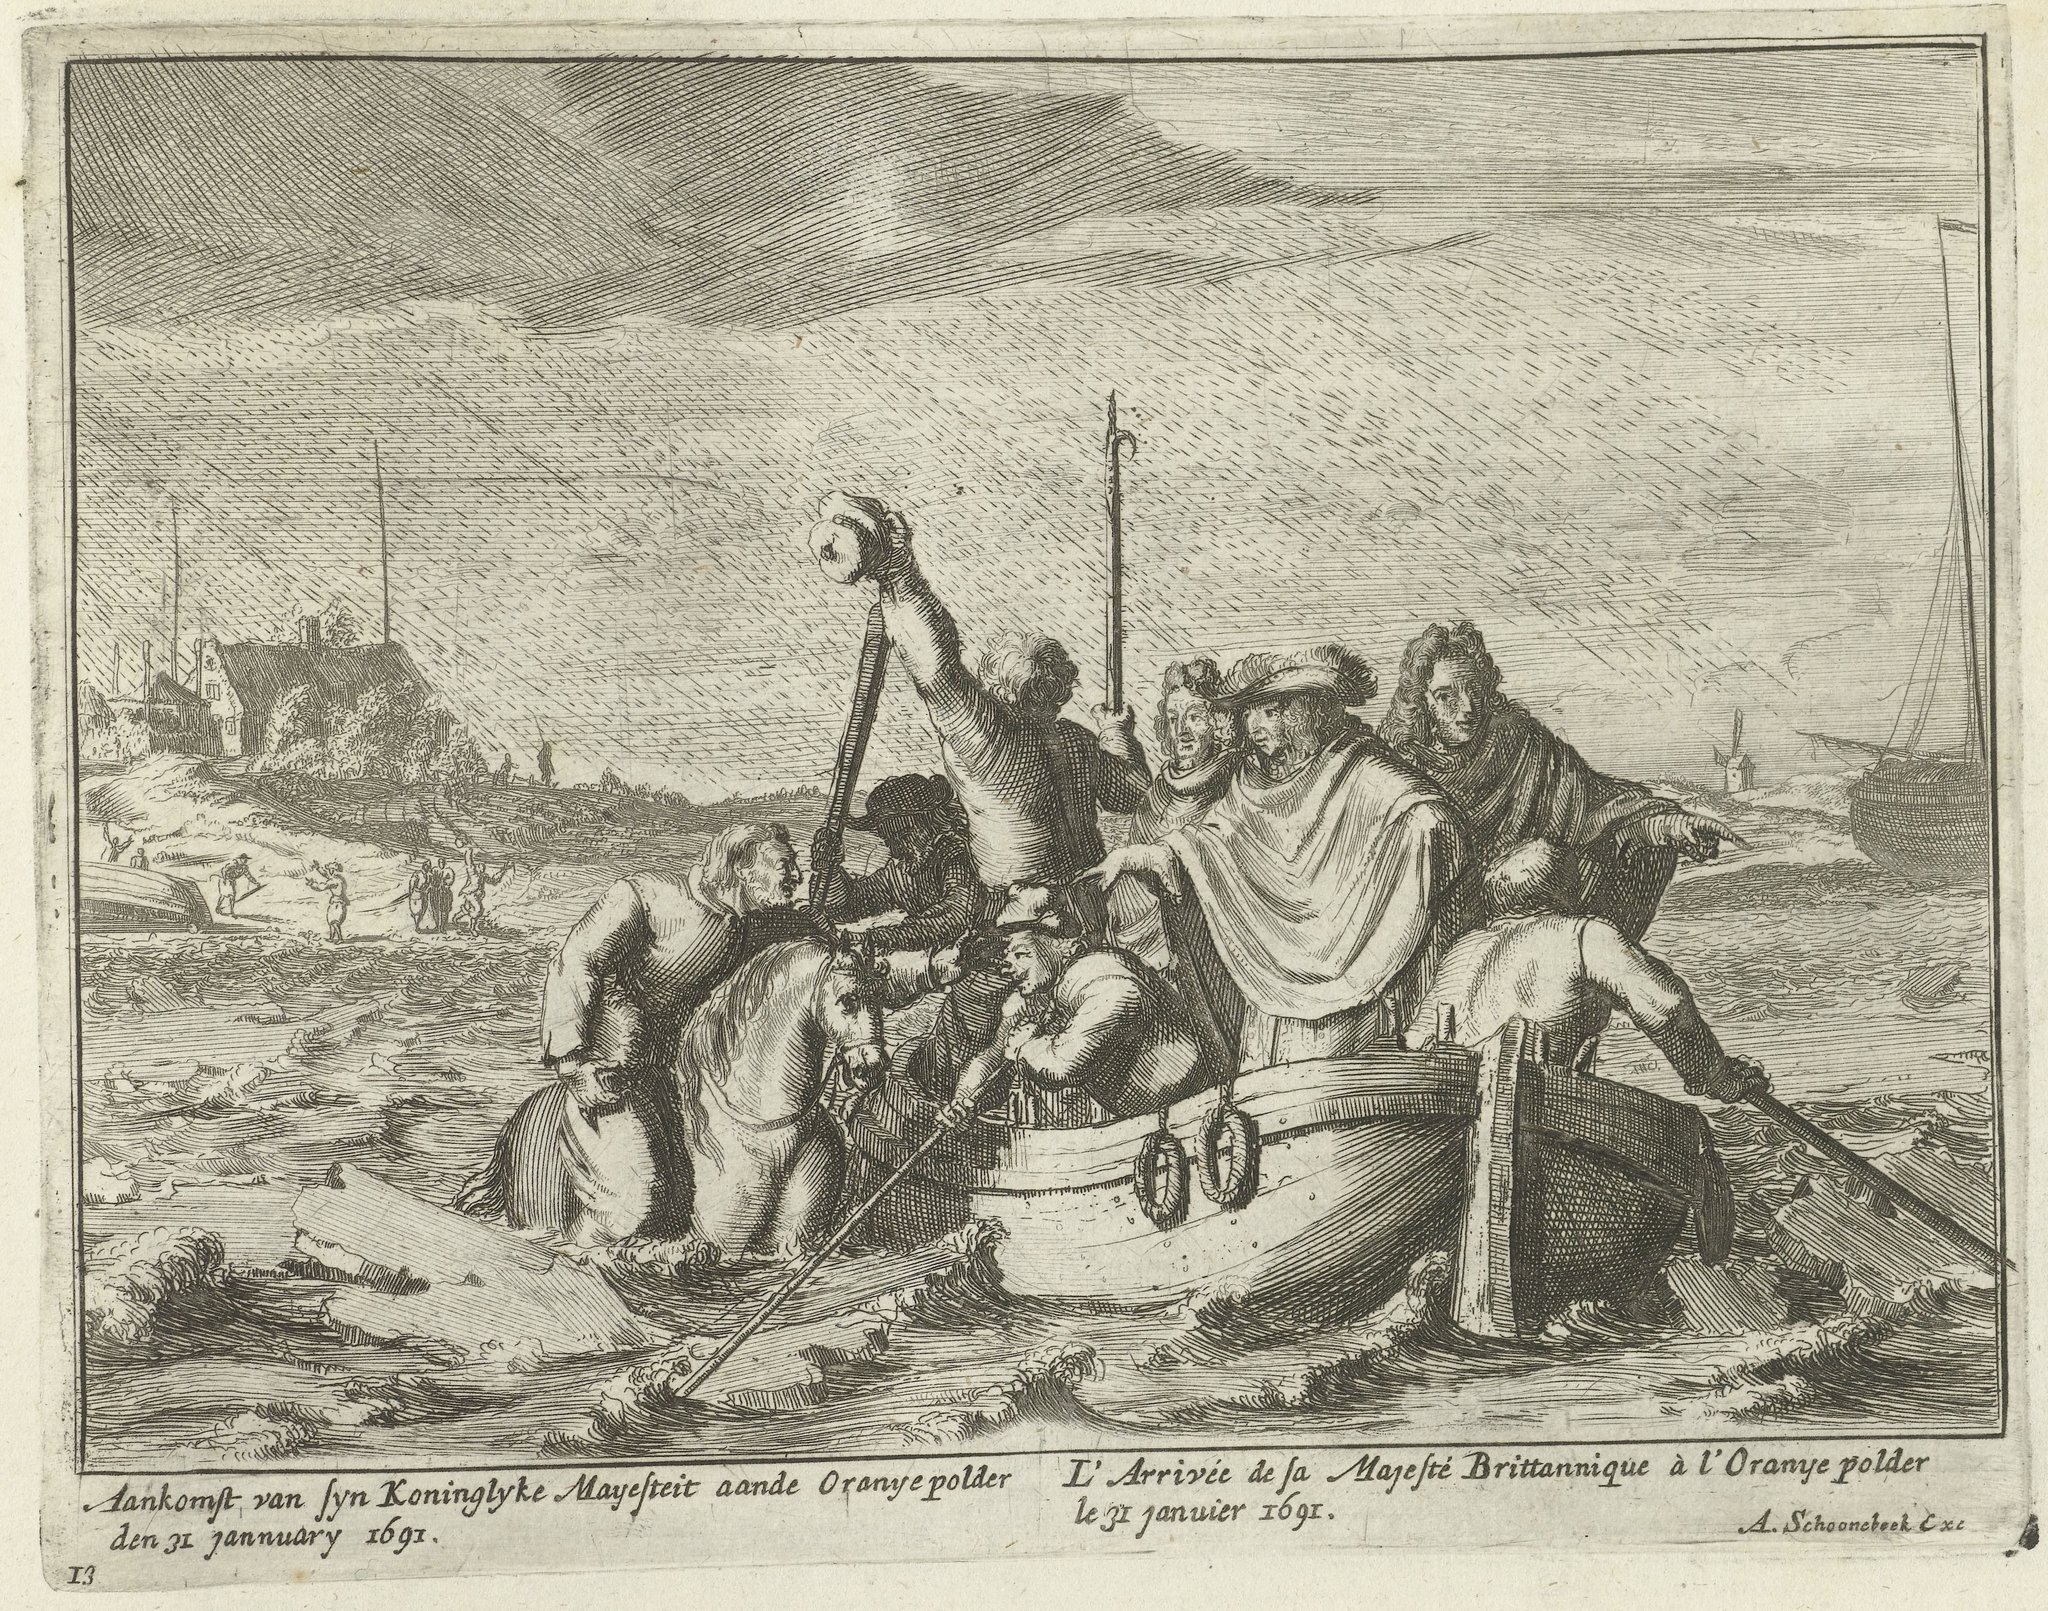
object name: print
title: Engelands schouwtoneel verbeeldende de voornaamste voorvallen in Yrland van 't Jaar 1690 tot de velttogt van S:K: Mayesteit van Groot Brittanie 1691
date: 1691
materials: paper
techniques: etching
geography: amsterdam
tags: the hague, william iii (prince of orange and king of england, scotland, and ireland), arrival and return ~ travelling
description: Aankomst van koning Willem III bij Oranjepolder in Zuid-Holland, 31 januari 1691. Door ijsvorming heeft de roeiboot met Willem III moeite aan land te komen. Plaat nr. 13 in de serie 'Engelants schouwtoneel' over de oorlog tussen Willem III en Jacobus II in de jaren 1690-1691 na de Glorious Revolution, (derde deel). Met onderschriften in het Nederlands en Frans.